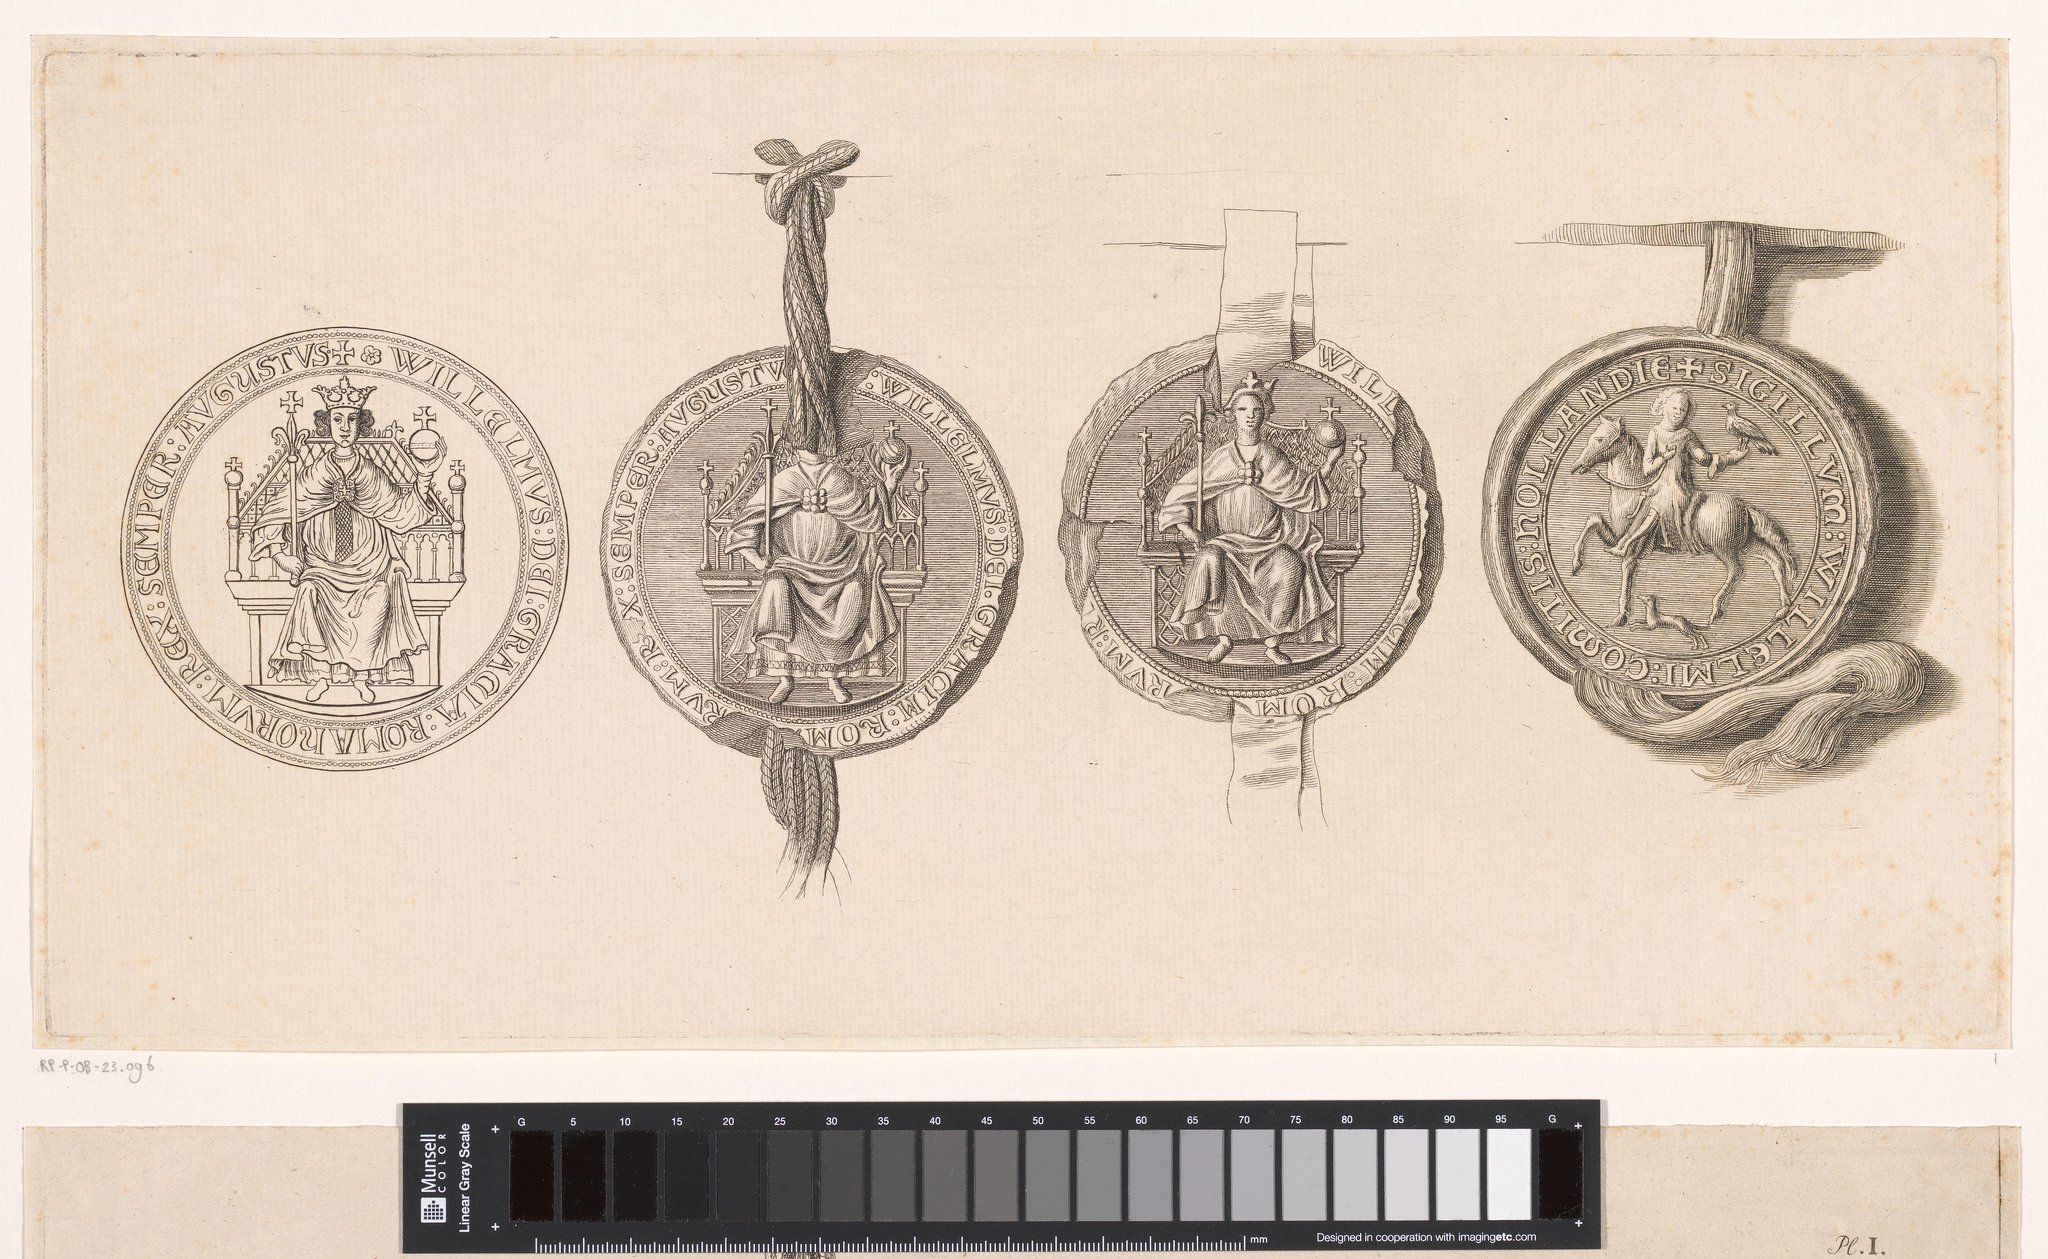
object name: print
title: Vier zegels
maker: pieter de mare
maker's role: print maker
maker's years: 1758-1796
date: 1768-1794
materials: paper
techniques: engraving, etching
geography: leiden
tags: seal, stamp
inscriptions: collector's mark: Lugt 240